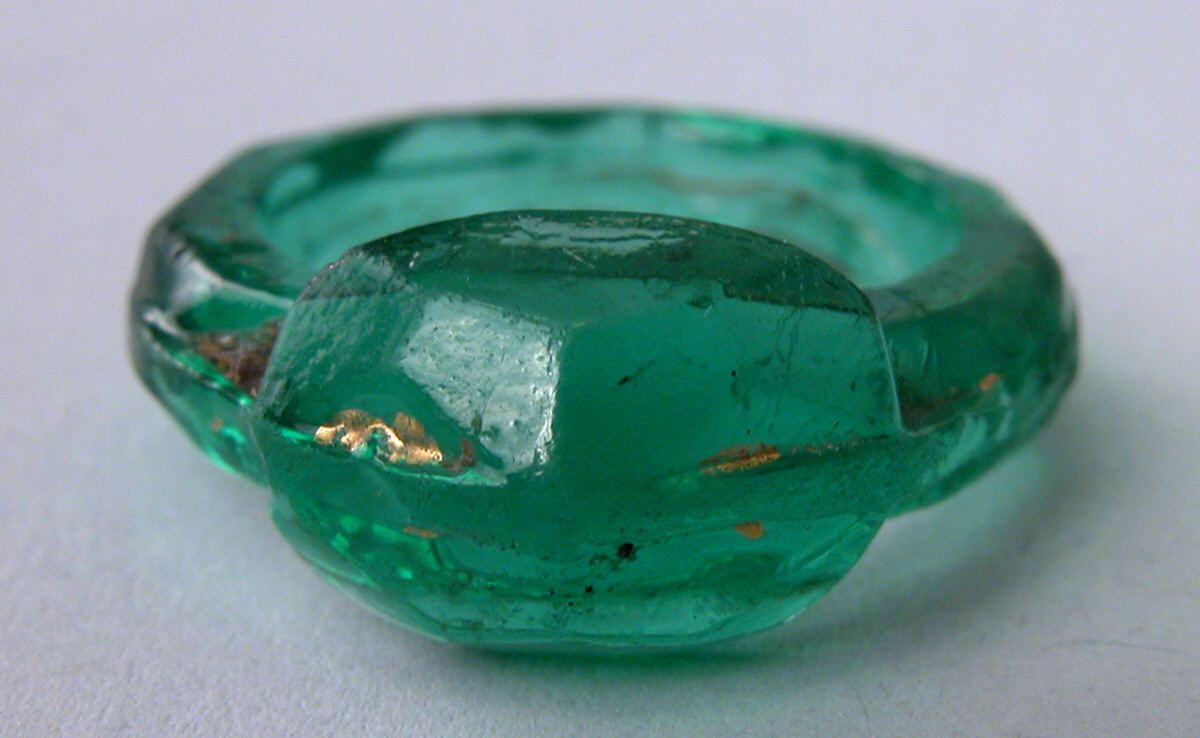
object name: ring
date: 1801-1900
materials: glass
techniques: glassblowing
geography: palestine